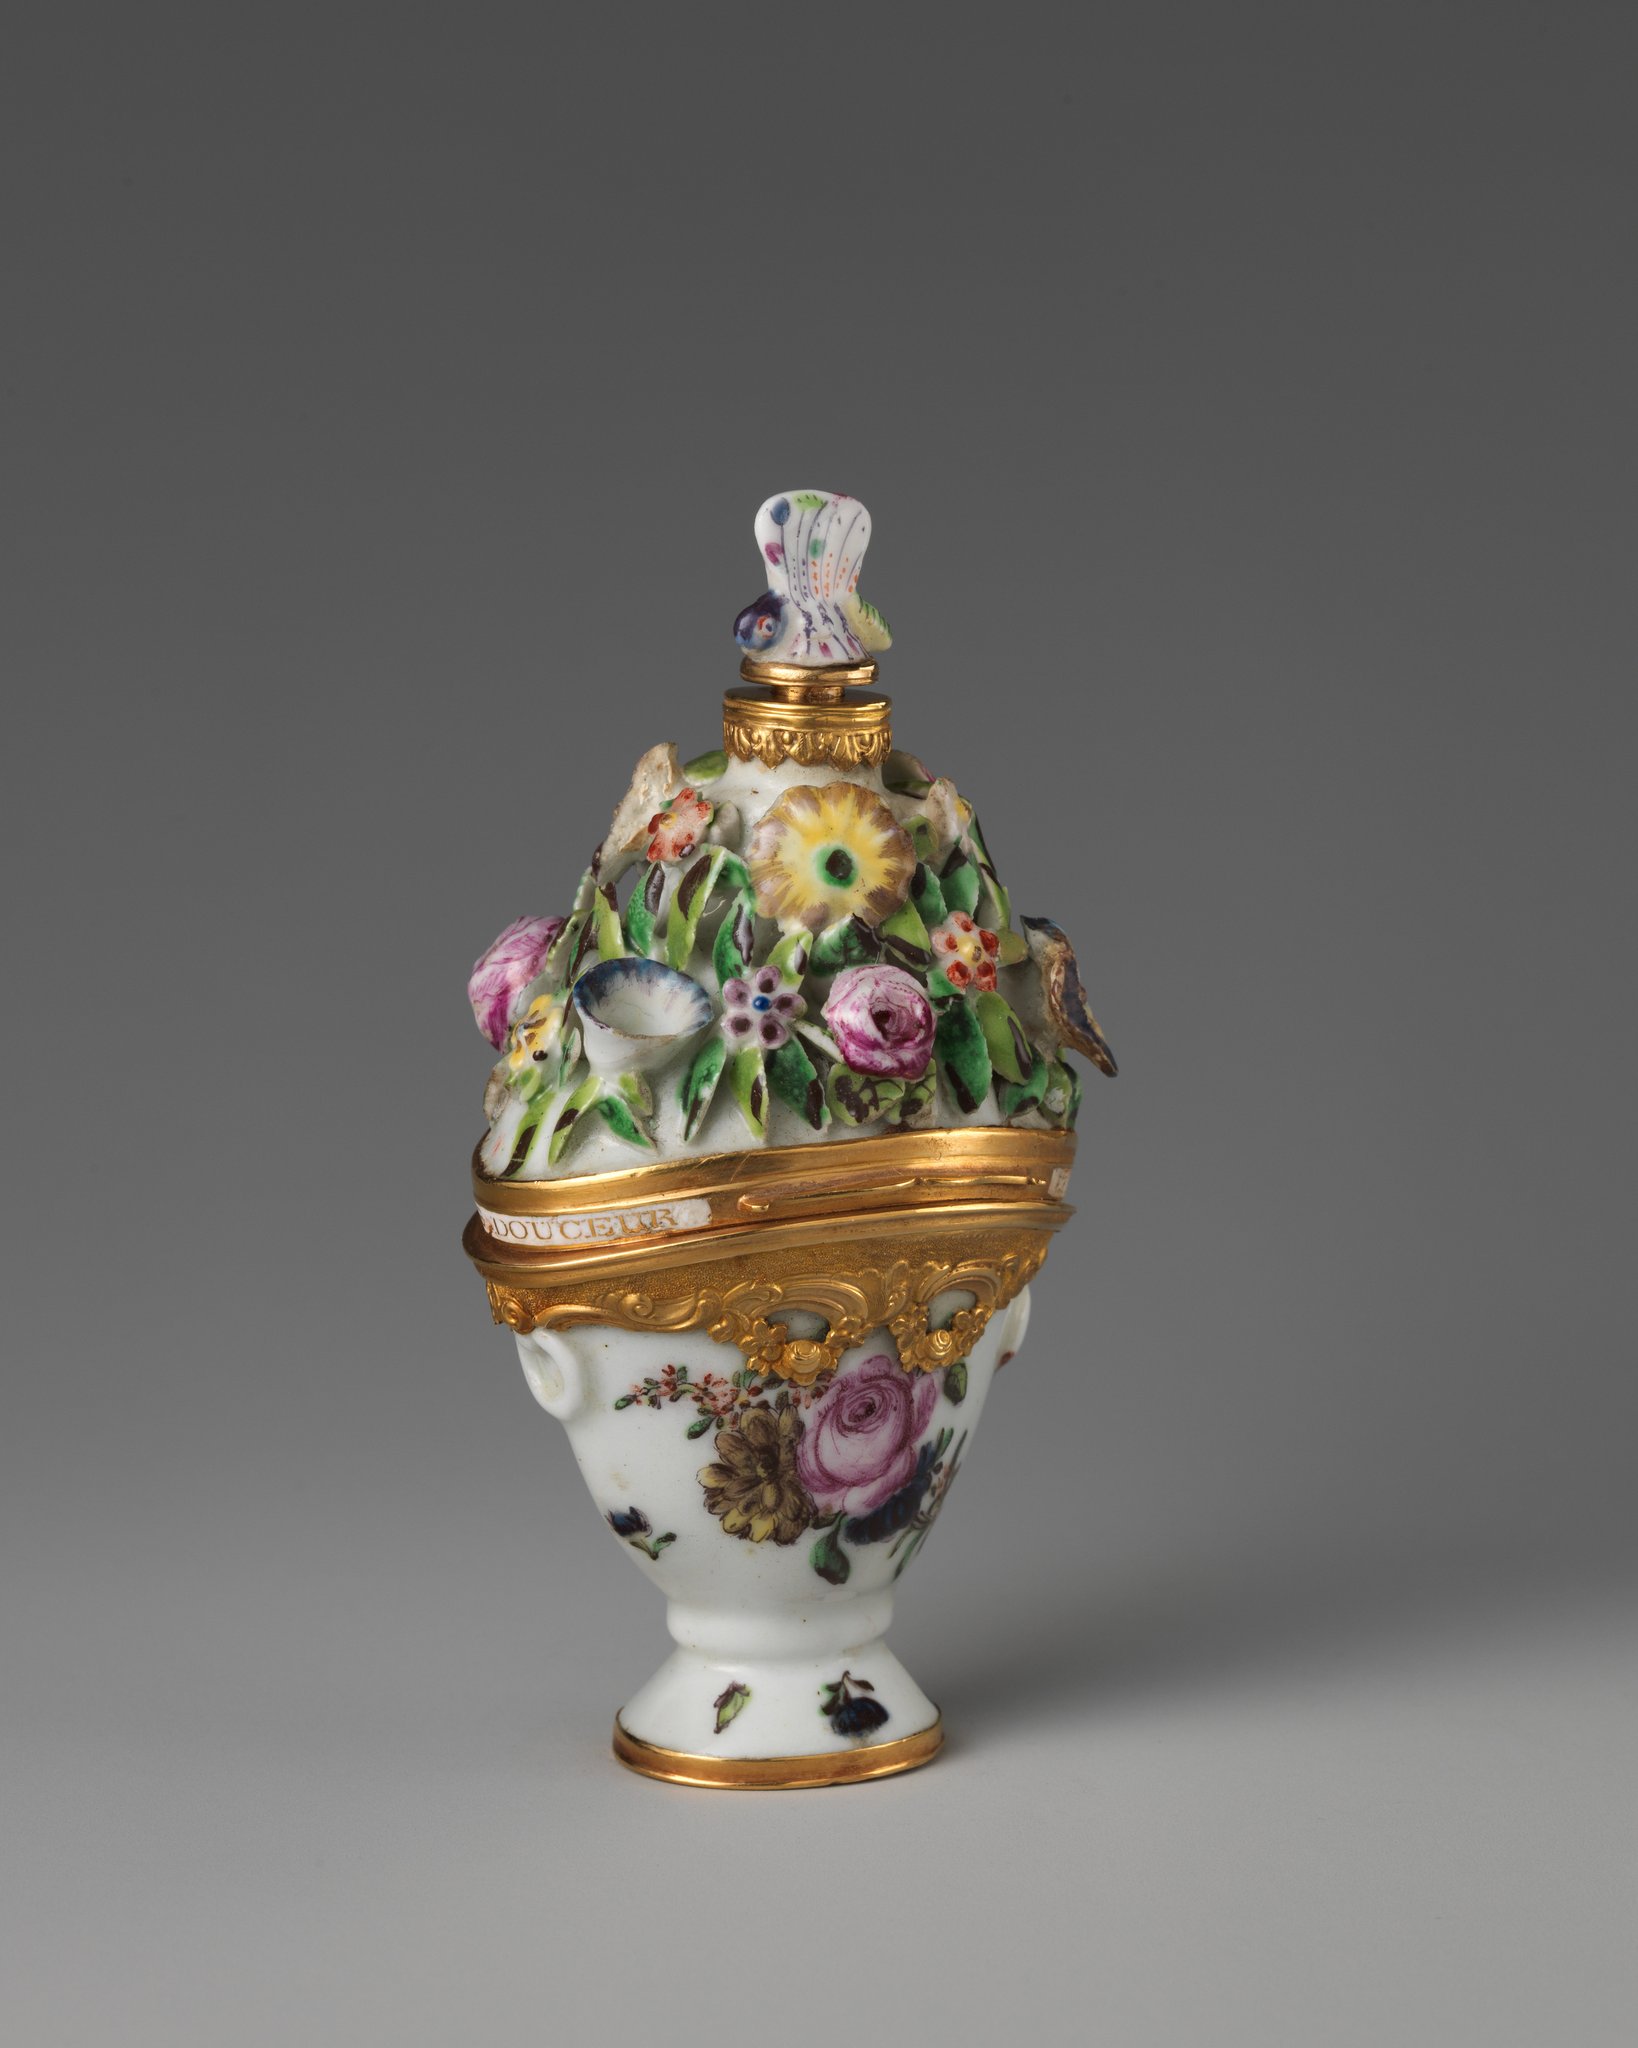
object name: scent bottle and box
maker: saint james's factory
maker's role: maker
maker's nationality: british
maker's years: 1749-1759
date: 1750-1755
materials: soft paste porcelain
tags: birds,flowers